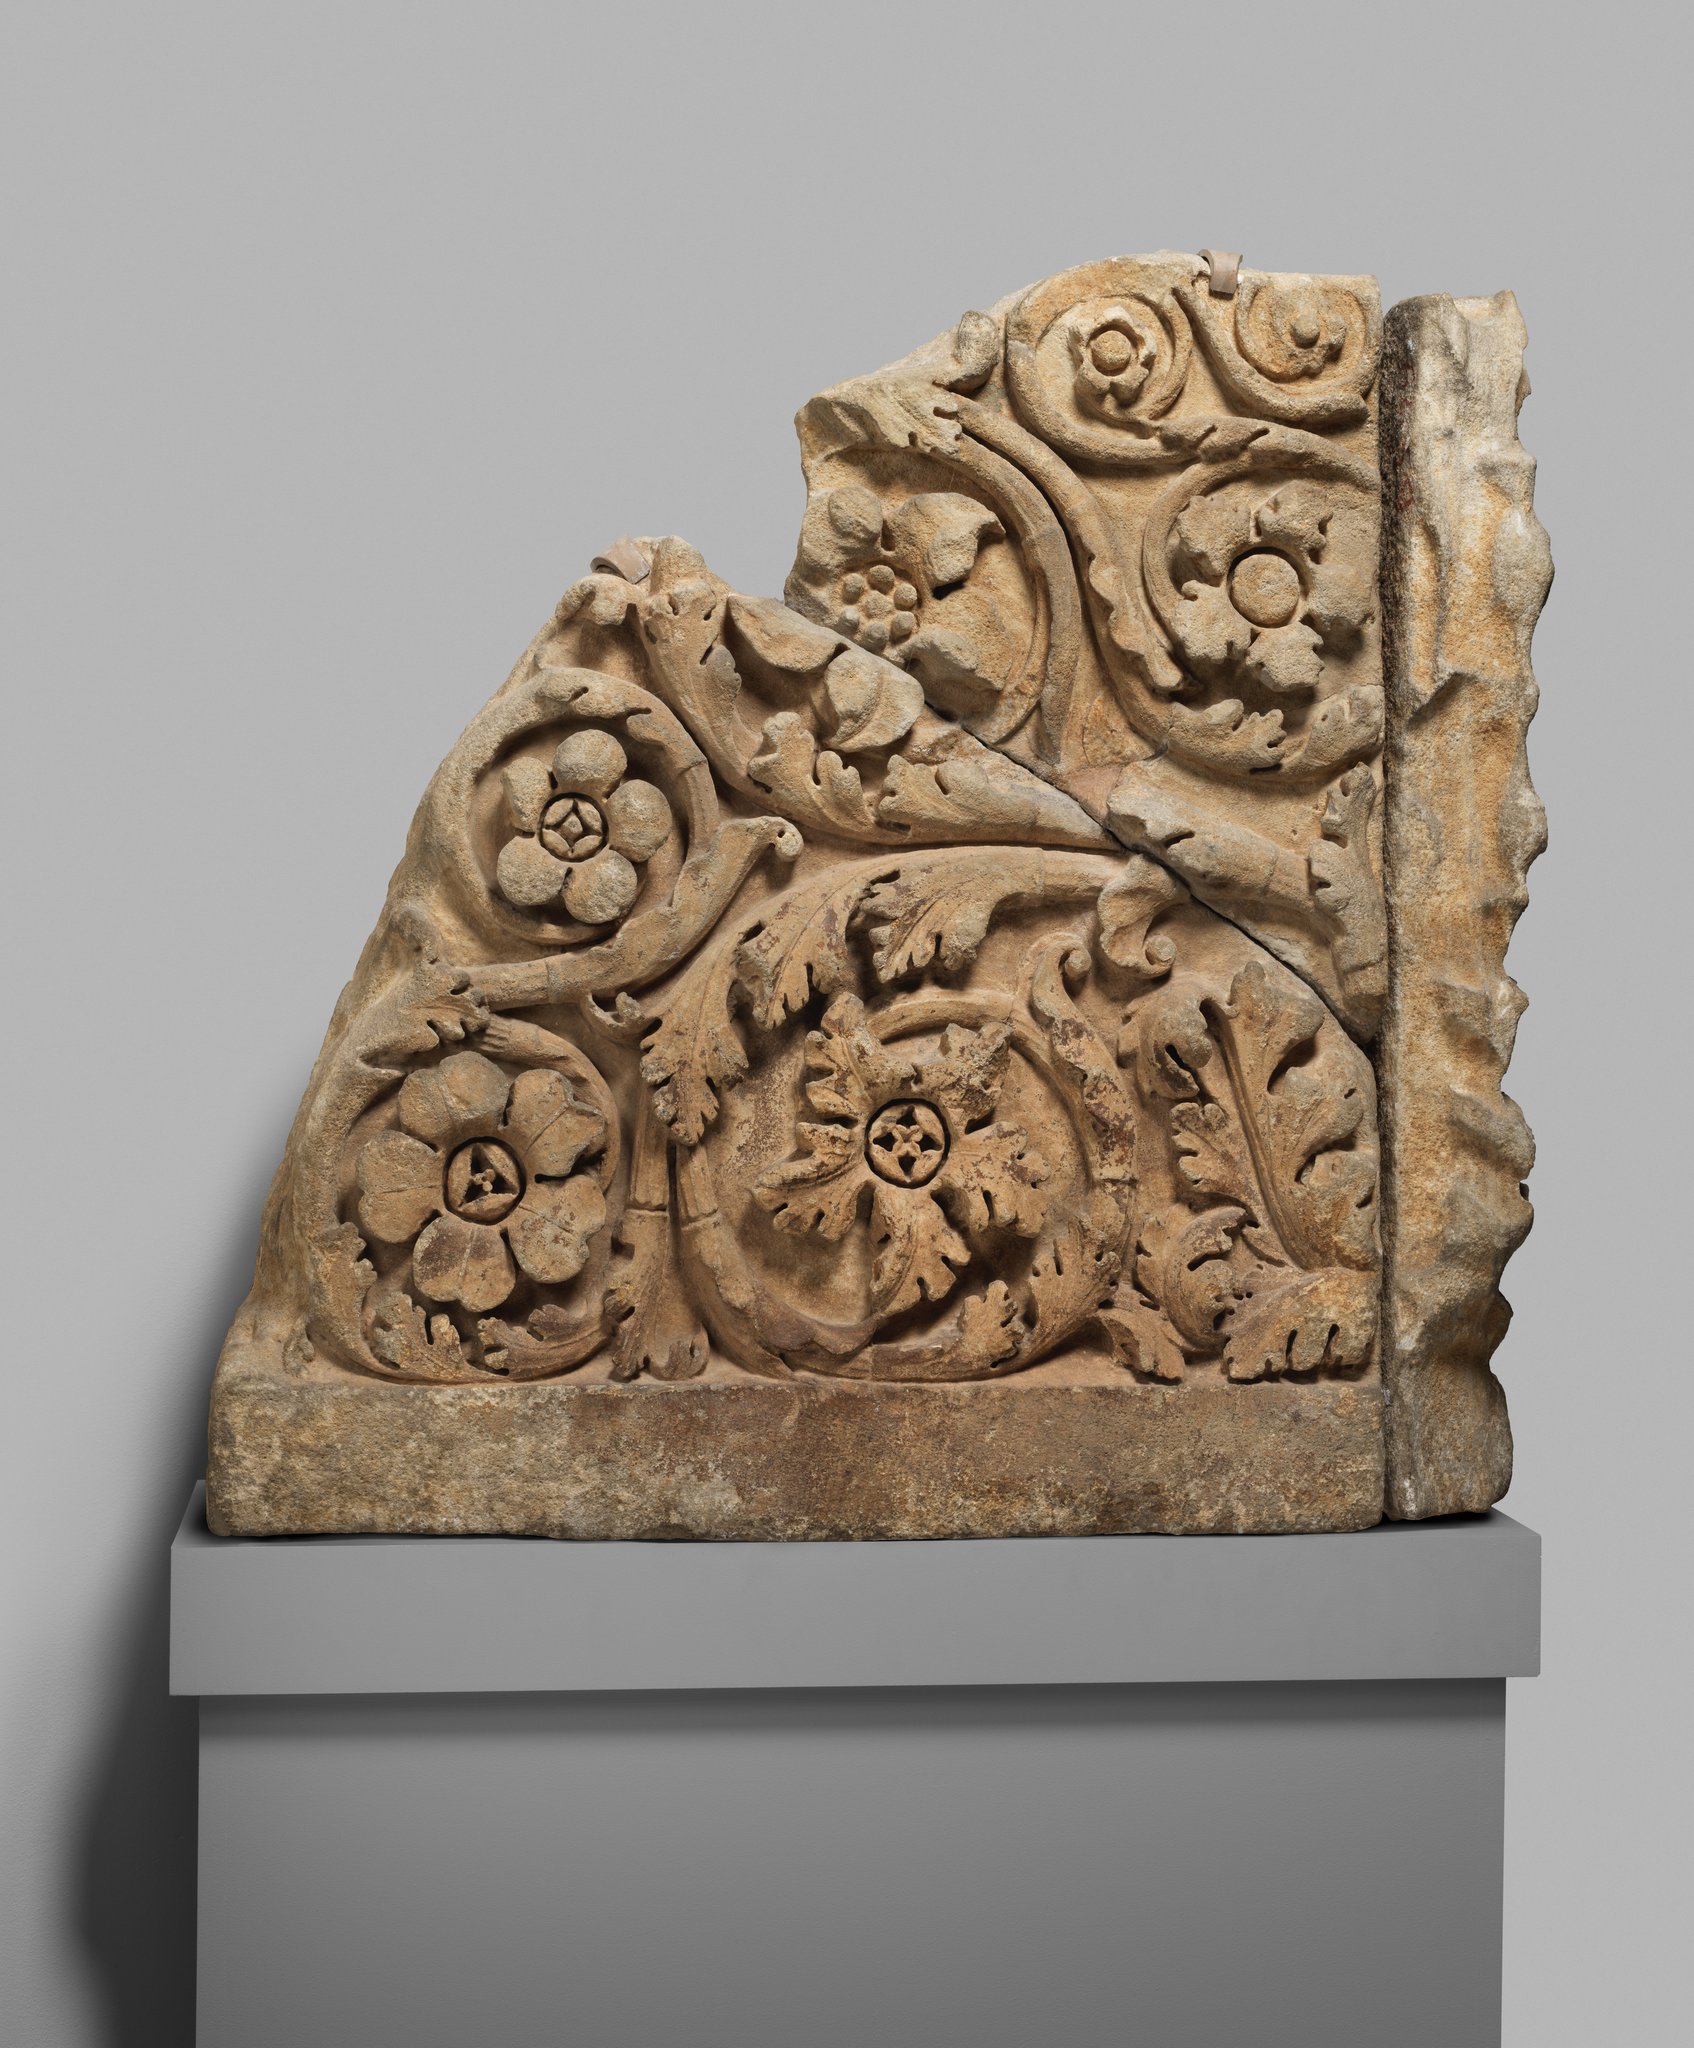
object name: akroterion with floral decoration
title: Marble acroterion with acanthus scrolls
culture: roman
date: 1-50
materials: marble